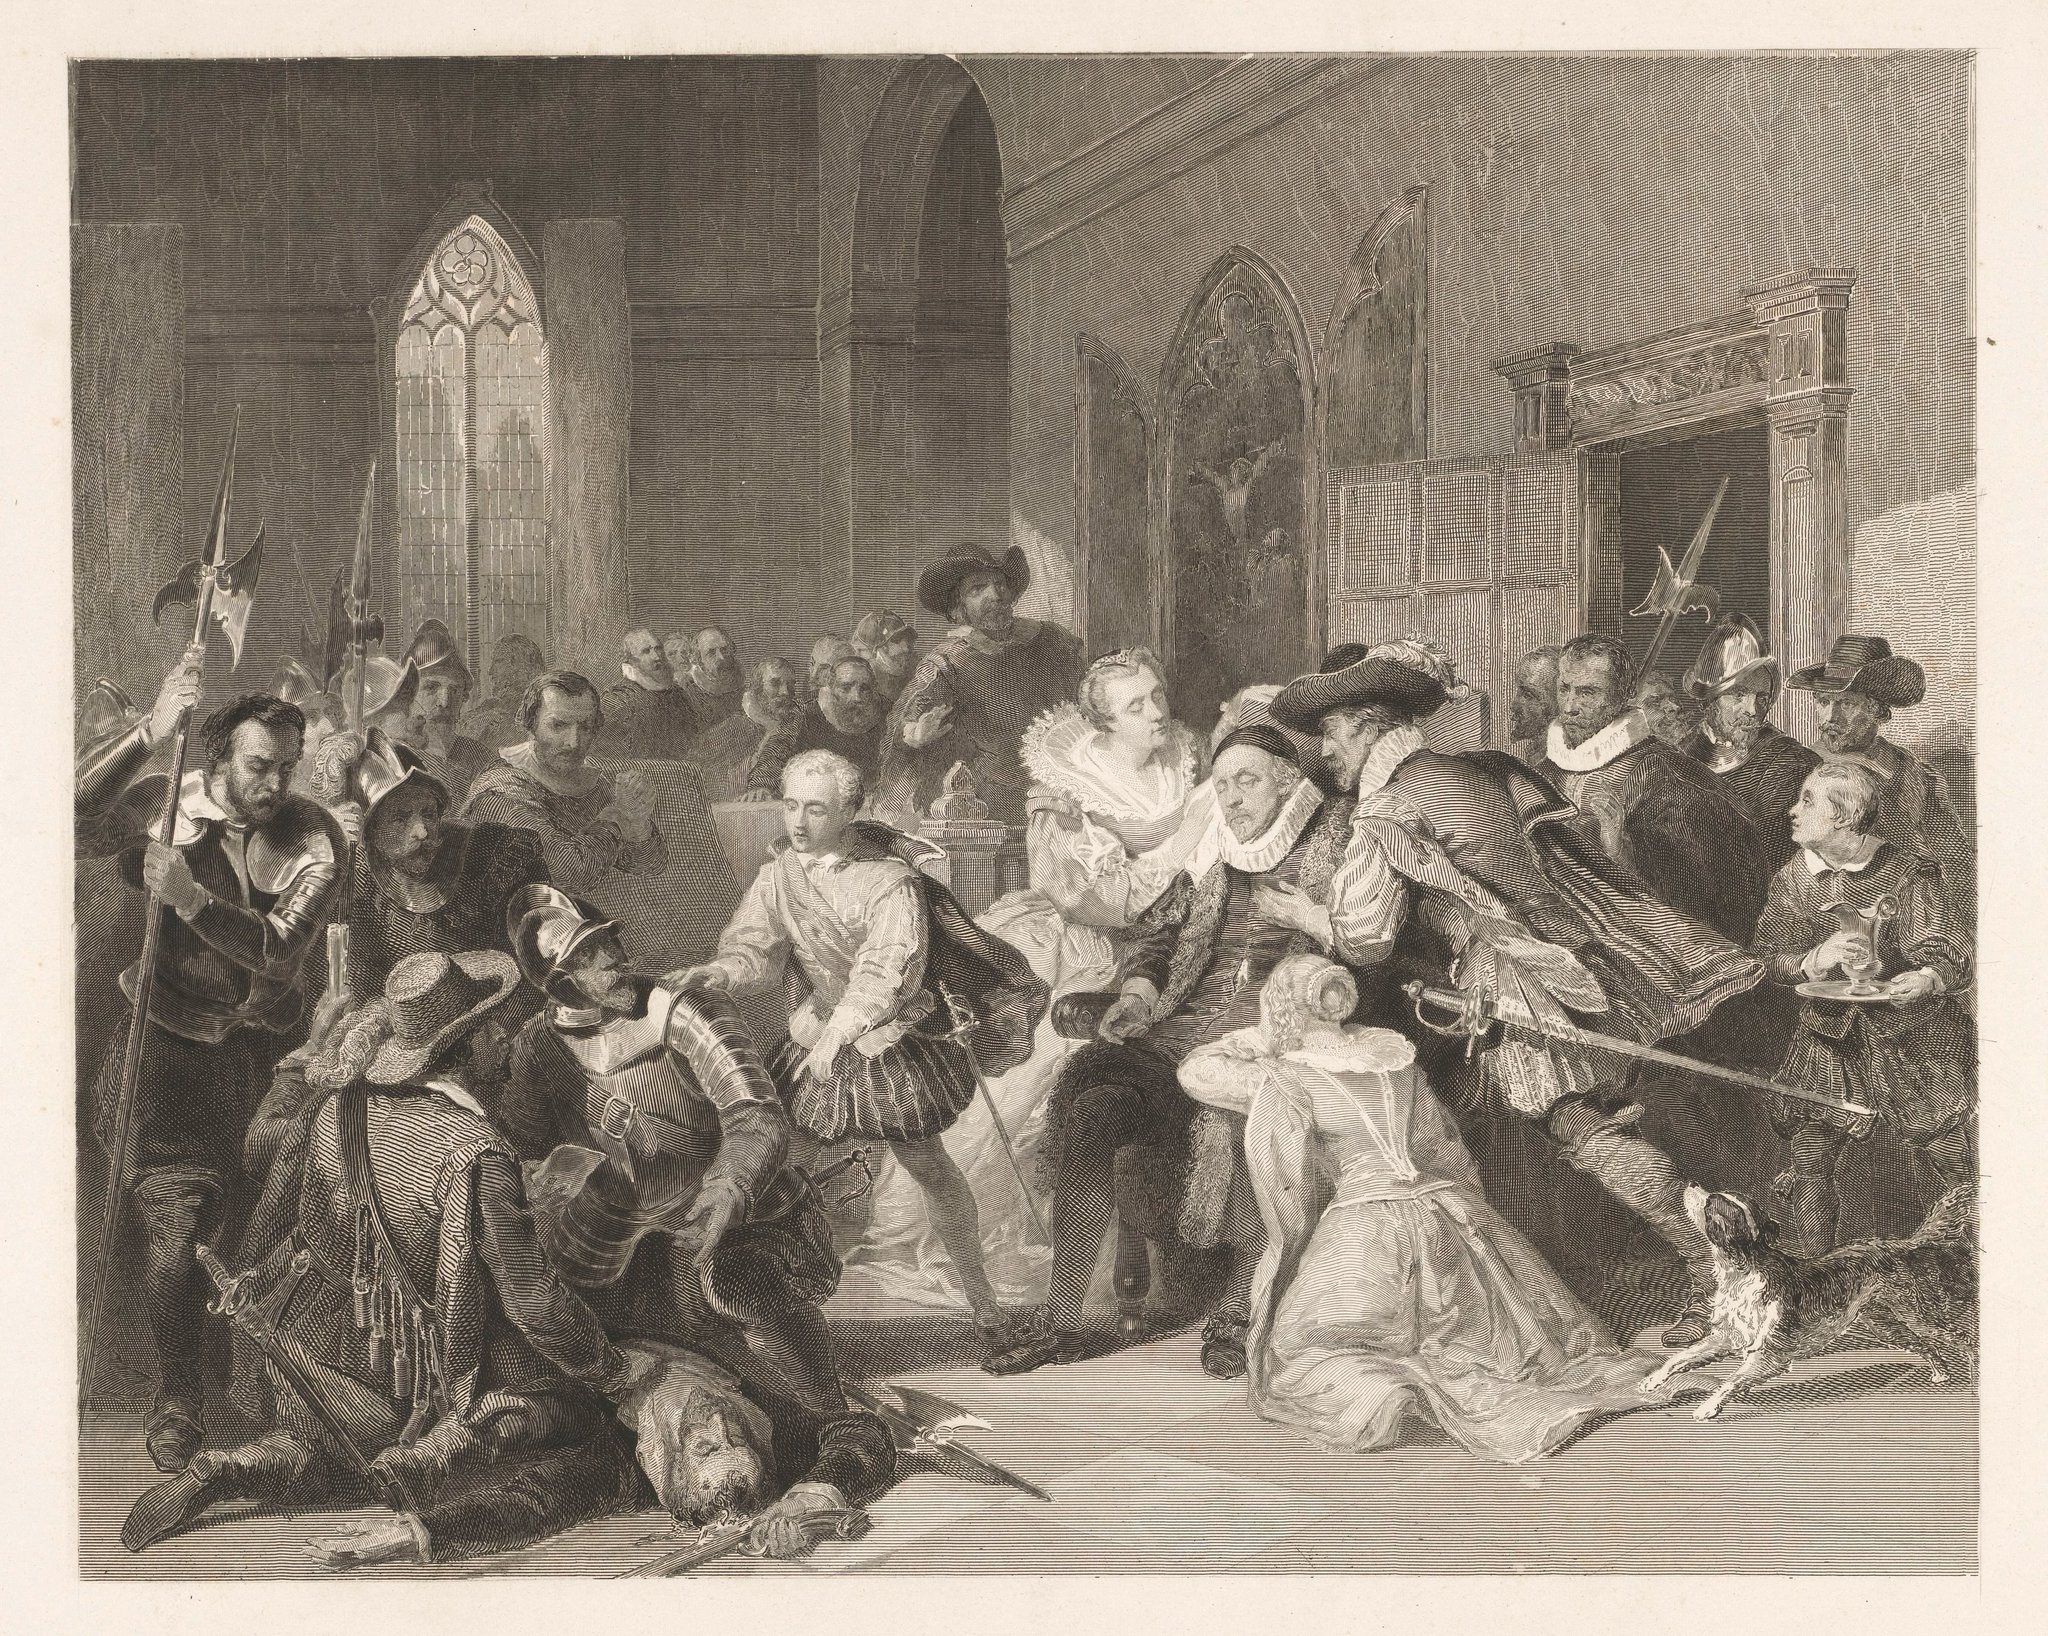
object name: history print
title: Aanslag van Jean de Jauregui op prins Willem I, 18 maart 1852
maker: johann wilhelm kaiser (i)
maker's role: draughtsman, print maker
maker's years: 1813-1900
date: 1855-1865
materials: paper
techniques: engraving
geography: netherlands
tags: antwerp, charlotte of bourbon, delft, william i (prince of orange), maurice (prince of orange), recovery, convalescence of sick person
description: Aanslag van Jean de Jauregui op prins Willem I, 18 maart 1852 te Antwerpen. Interieur met de prins zittend gewond in een stoel, om hem heen familie en anderen. Links ligt het lichaam van de gedode Jean de Jauregui op de vloer, Maurits vraagt de soldaten hem te onderzoeken.